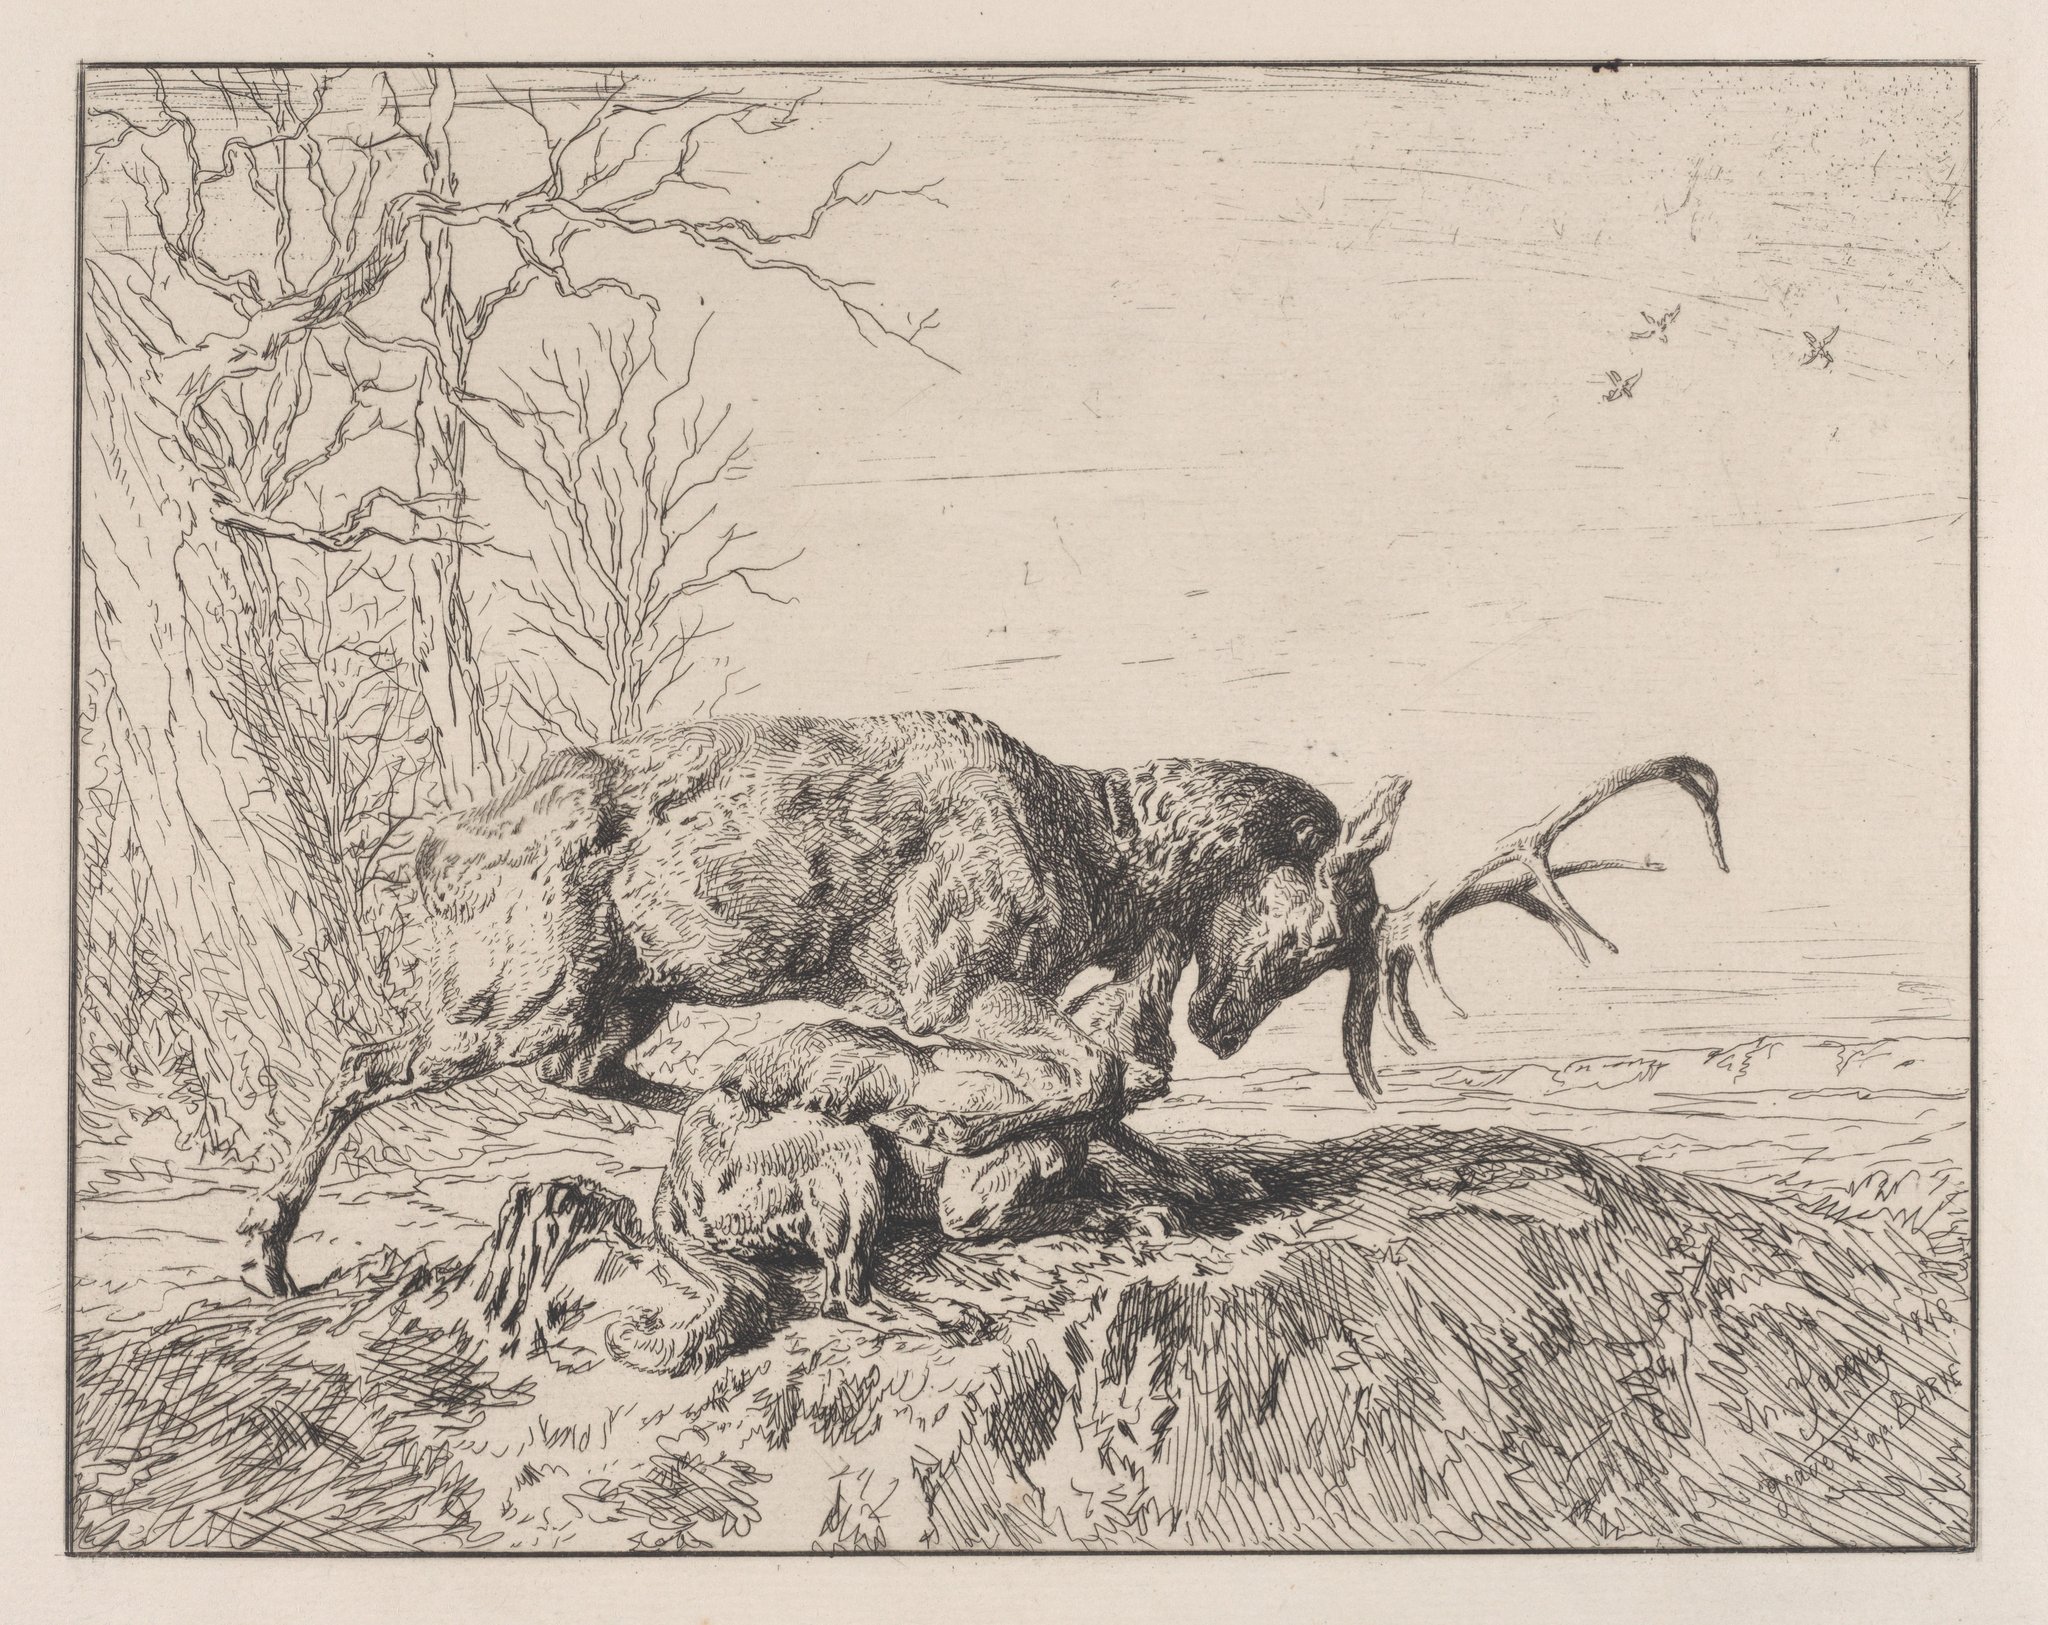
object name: print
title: Stag Fighting a Wolf, after Antoine Louis Barye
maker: charles émile jacque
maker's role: artist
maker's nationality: french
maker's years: 1813-1894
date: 1846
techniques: etching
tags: deer,wolves